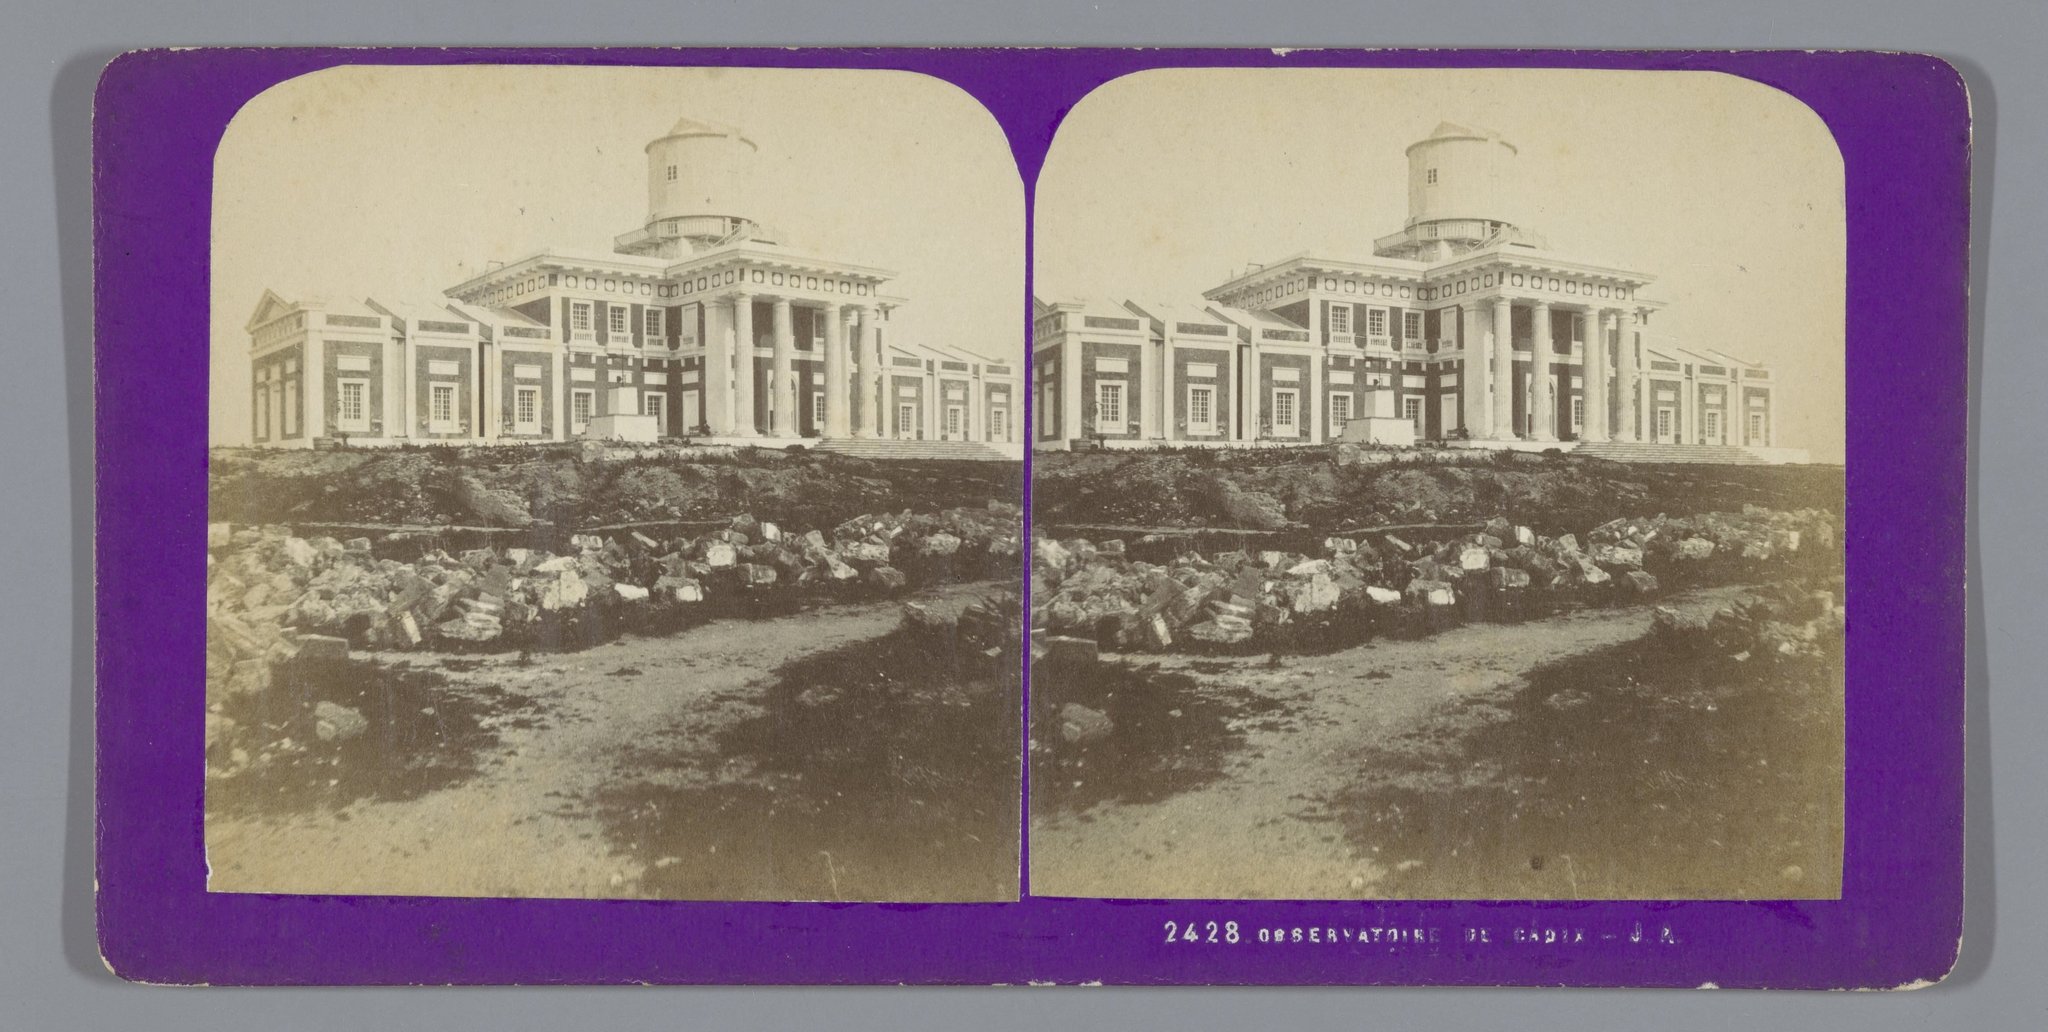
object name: stereograph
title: Observatoire de Cadix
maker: jean andrieu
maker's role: fotograaf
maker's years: 1816-1872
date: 1862-1876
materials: cardboard, photographic support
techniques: albumen print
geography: san fernando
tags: observatory (~ astronomy)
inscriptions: number: ‘2428’